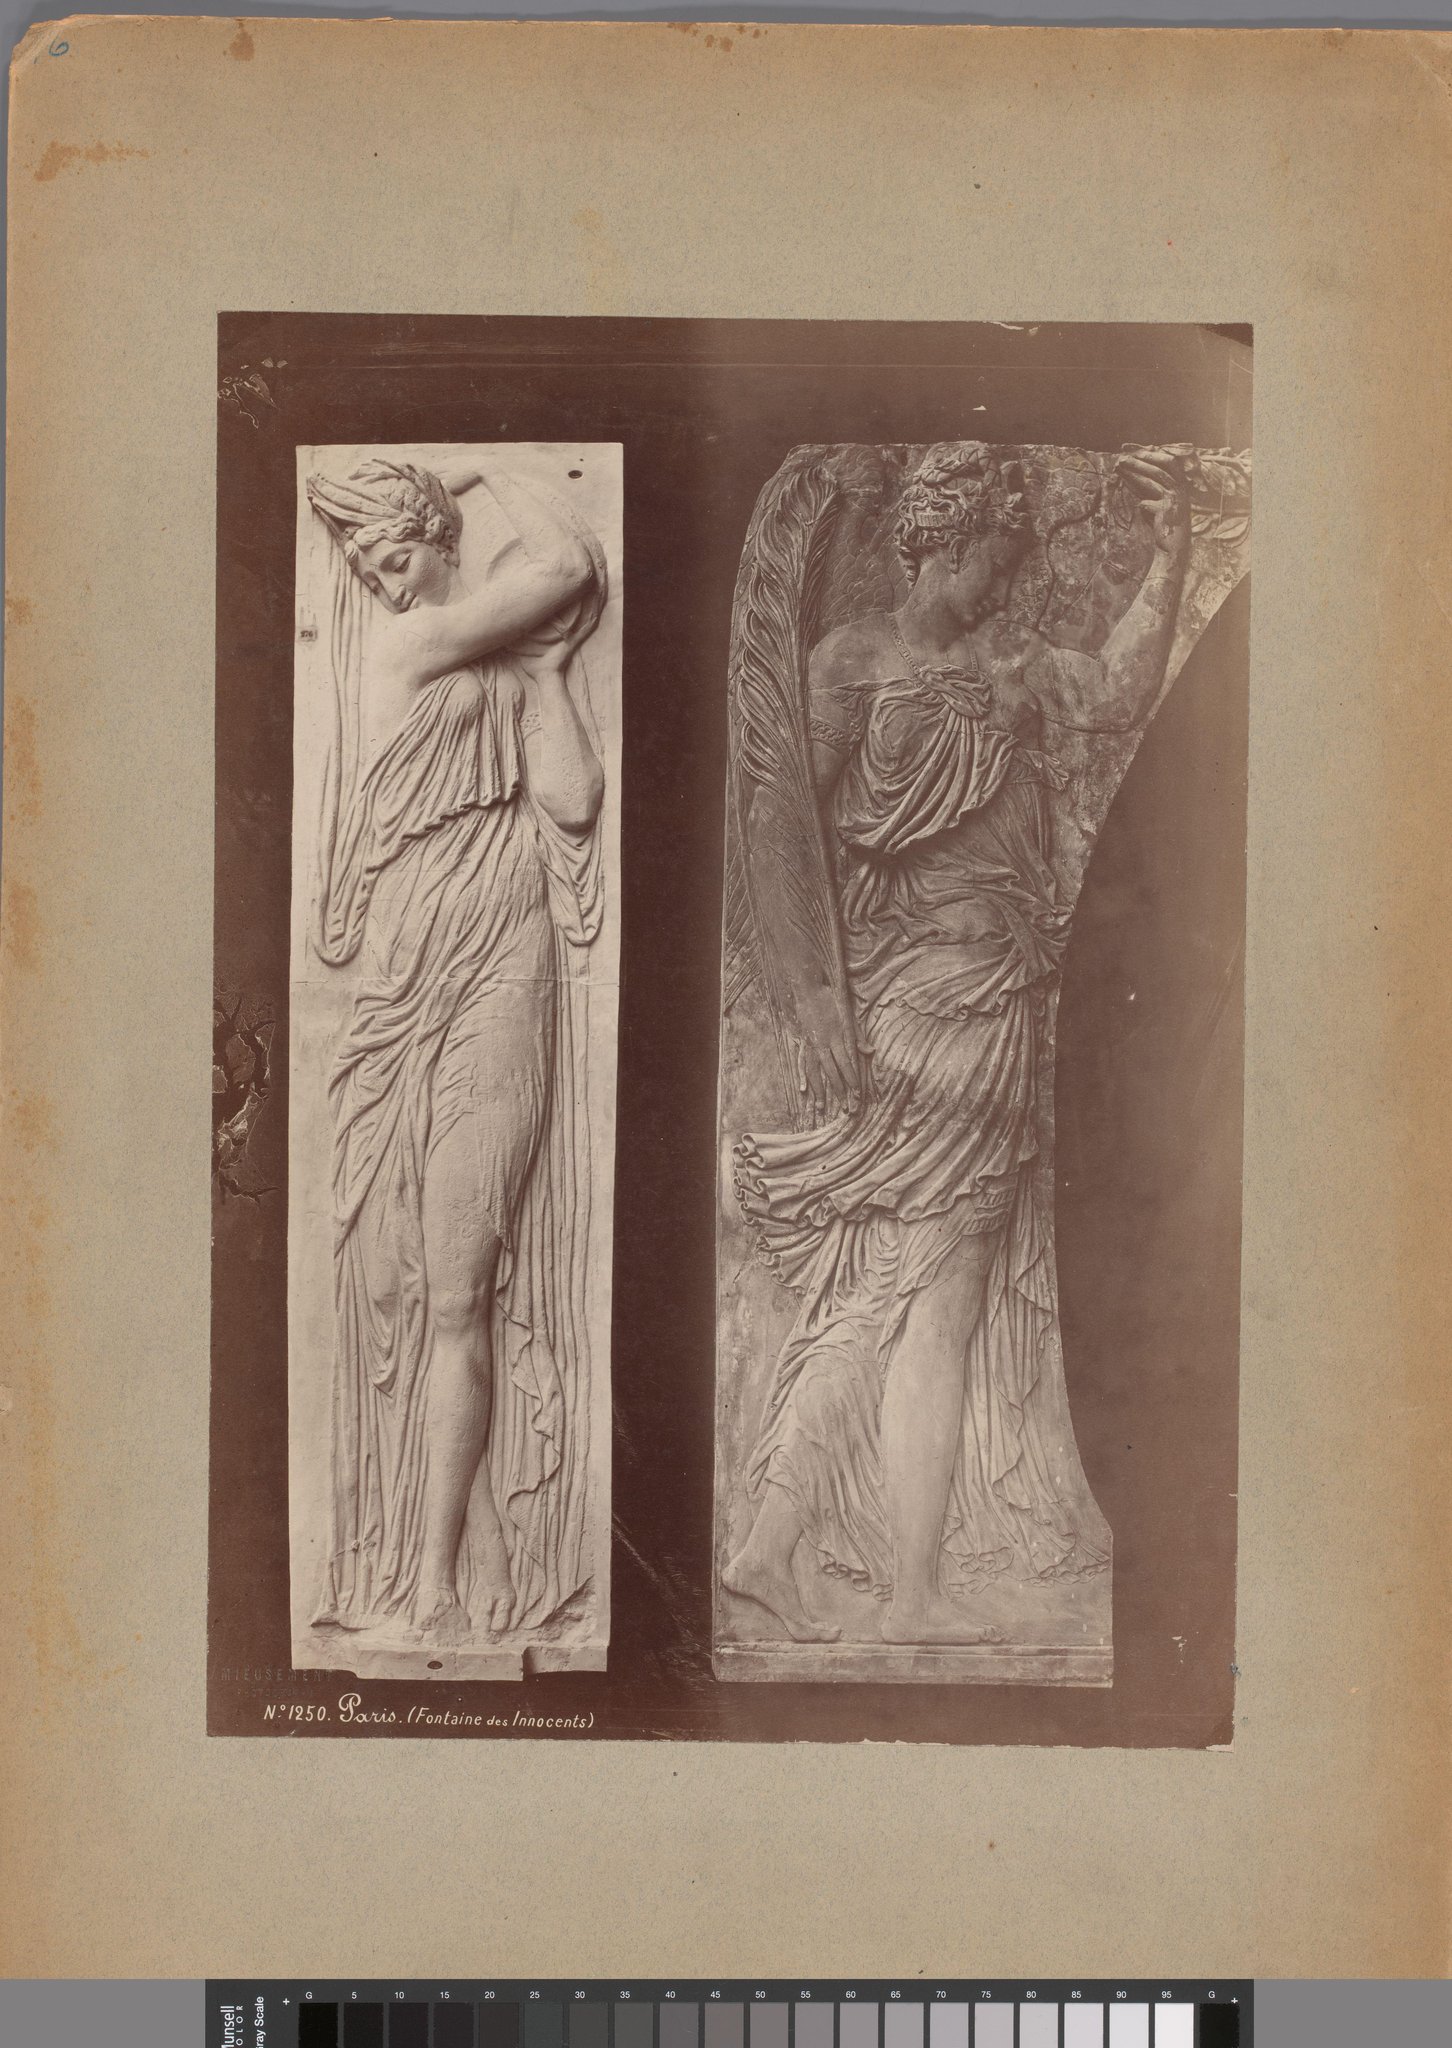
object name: photograph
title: Mogelijk afgietsel van nymphen als afgebeeld op de Fontaine des Innocents te Parijs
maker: séraphin-médéric mieusement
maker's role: fotograaf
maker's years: 1840-1905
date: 1850-1900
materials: cardboard, photographic support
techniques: albumen print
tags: sculpture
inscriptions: number: ‘No. 1250’, workshop stamp: ‘MIEUSEMENT/ photographe’, retailer's mark: ‘Kunstboekhandel/ J.A.G. De Leur/ Photograaf- Uitgever/ Huigenspark, 40b./ Den Haag’, collector's mark: ‘Rijks normaalschool voor teekenonderwijzers Amsterdam’